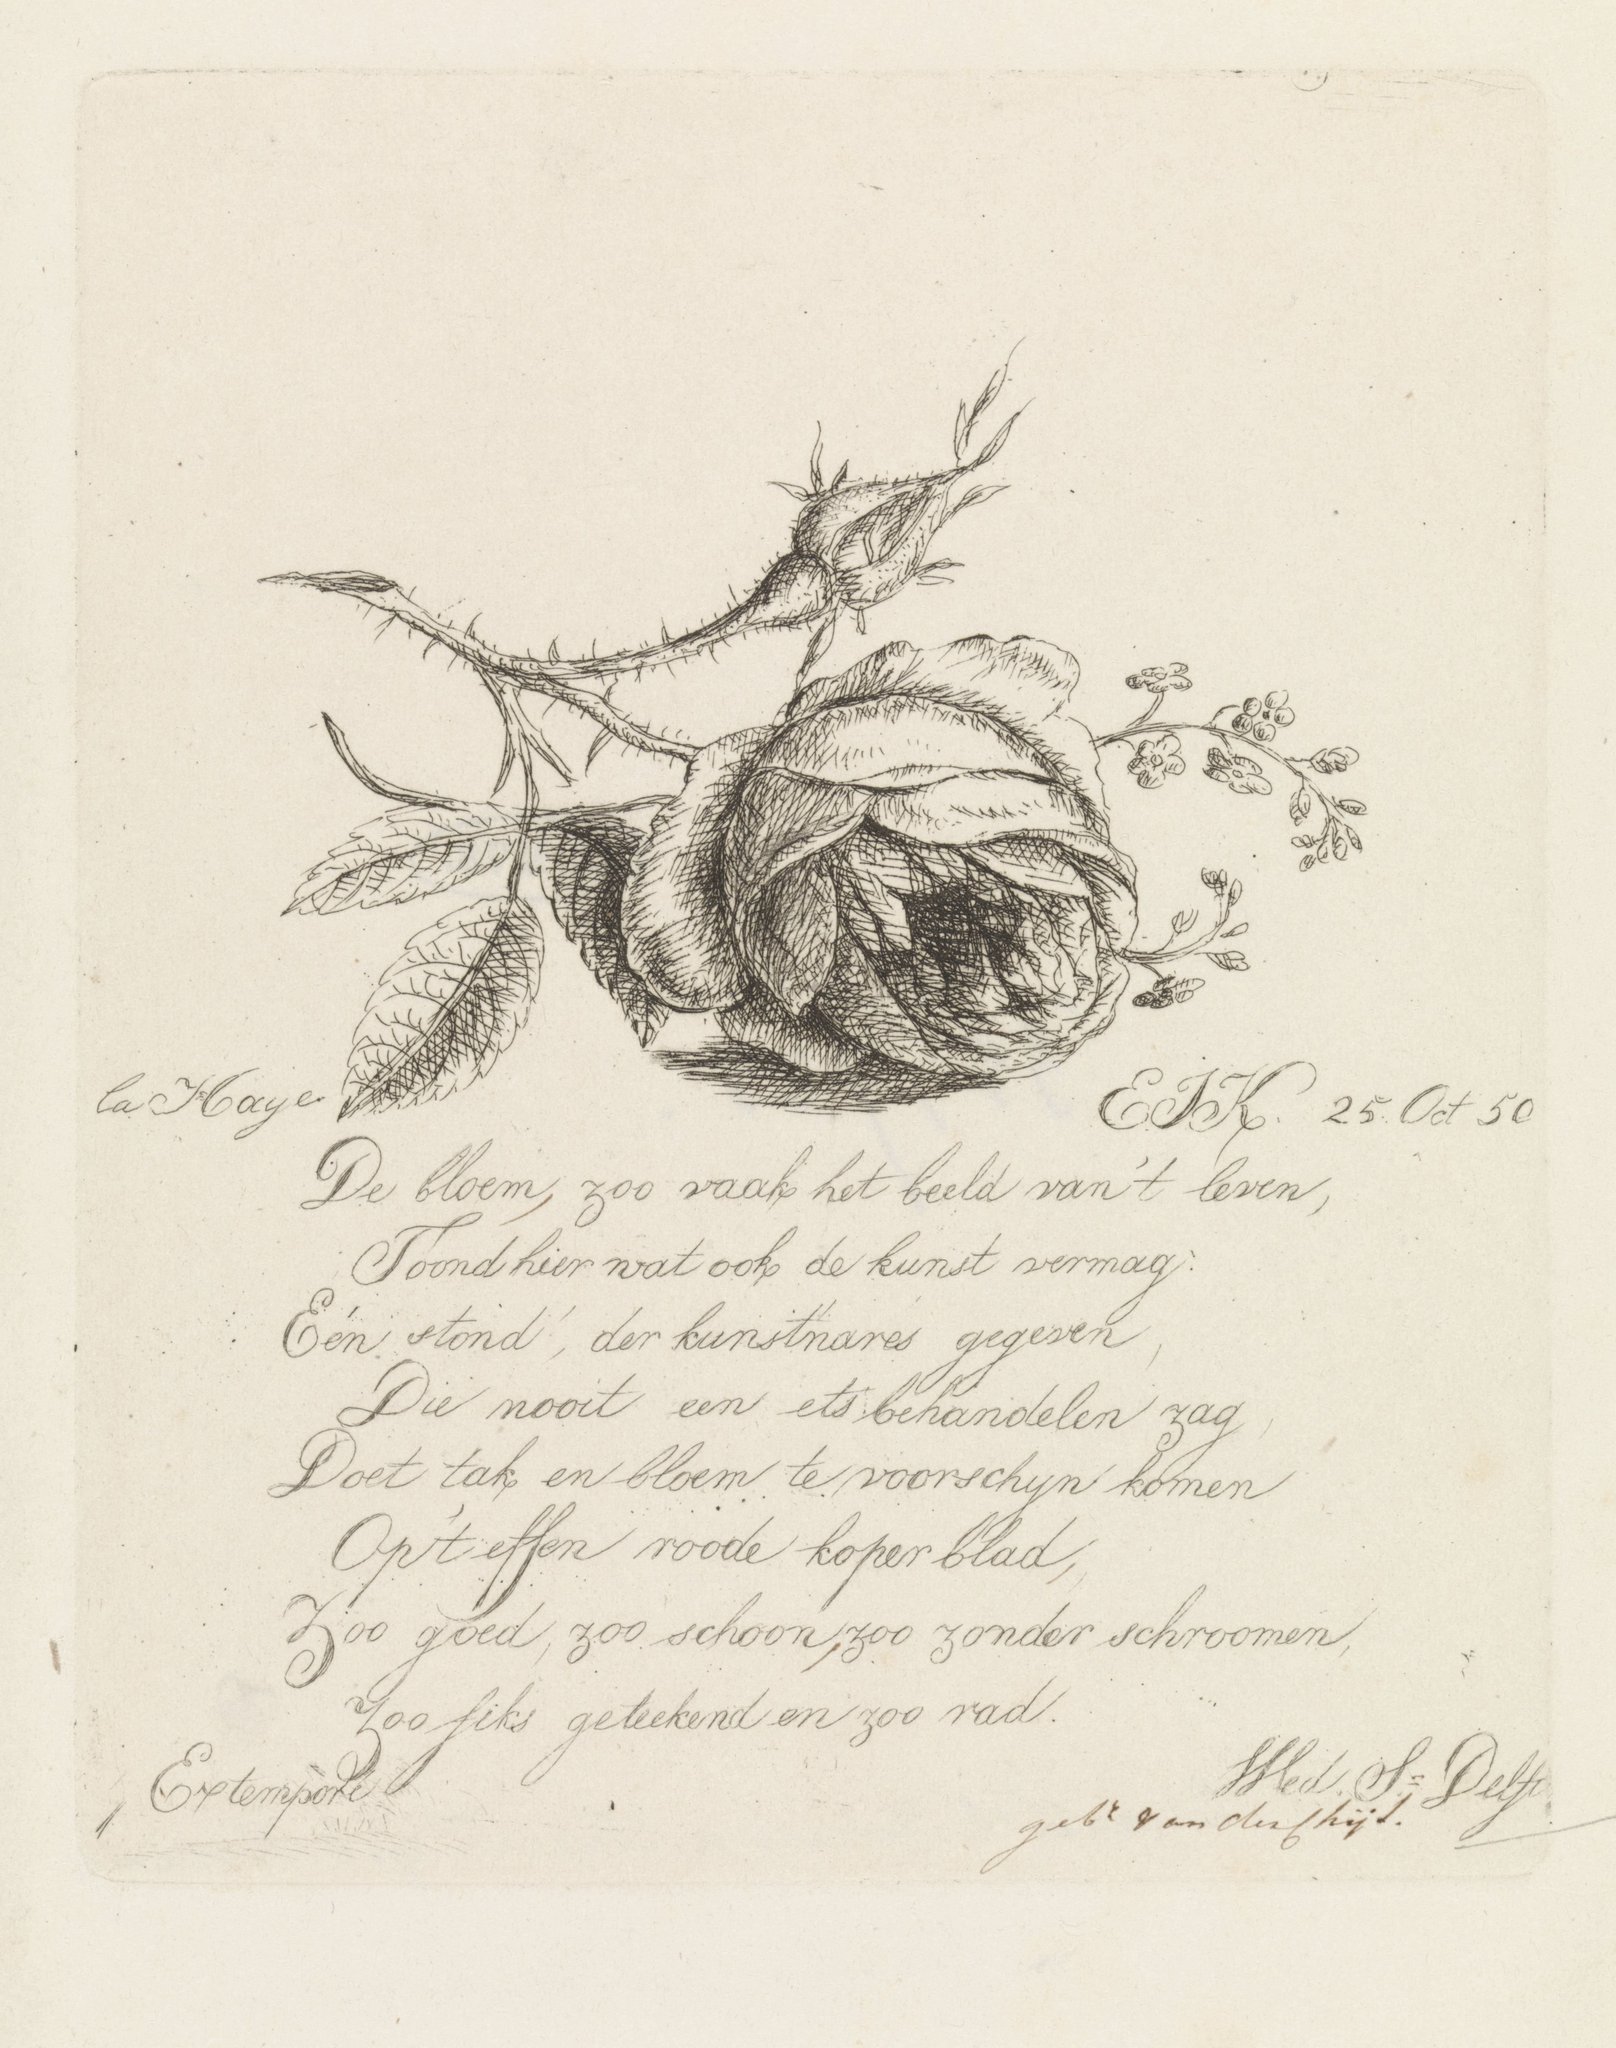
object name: print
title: Een roos en vergeet-mij-nietjes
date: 1850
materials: paper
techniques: etching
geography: the hague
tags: flowers, flowers: rose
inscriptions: collector's mark: Lugt 2760, collector's mark: Lugt 2228, inscription: ‘A.M.M. v.d. Chijs’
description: Studie van een afgesneden roos, met een bloem en een knop, en vergeet-mij-nietjes. Onder de afbeelding staat een achtregelig vers.